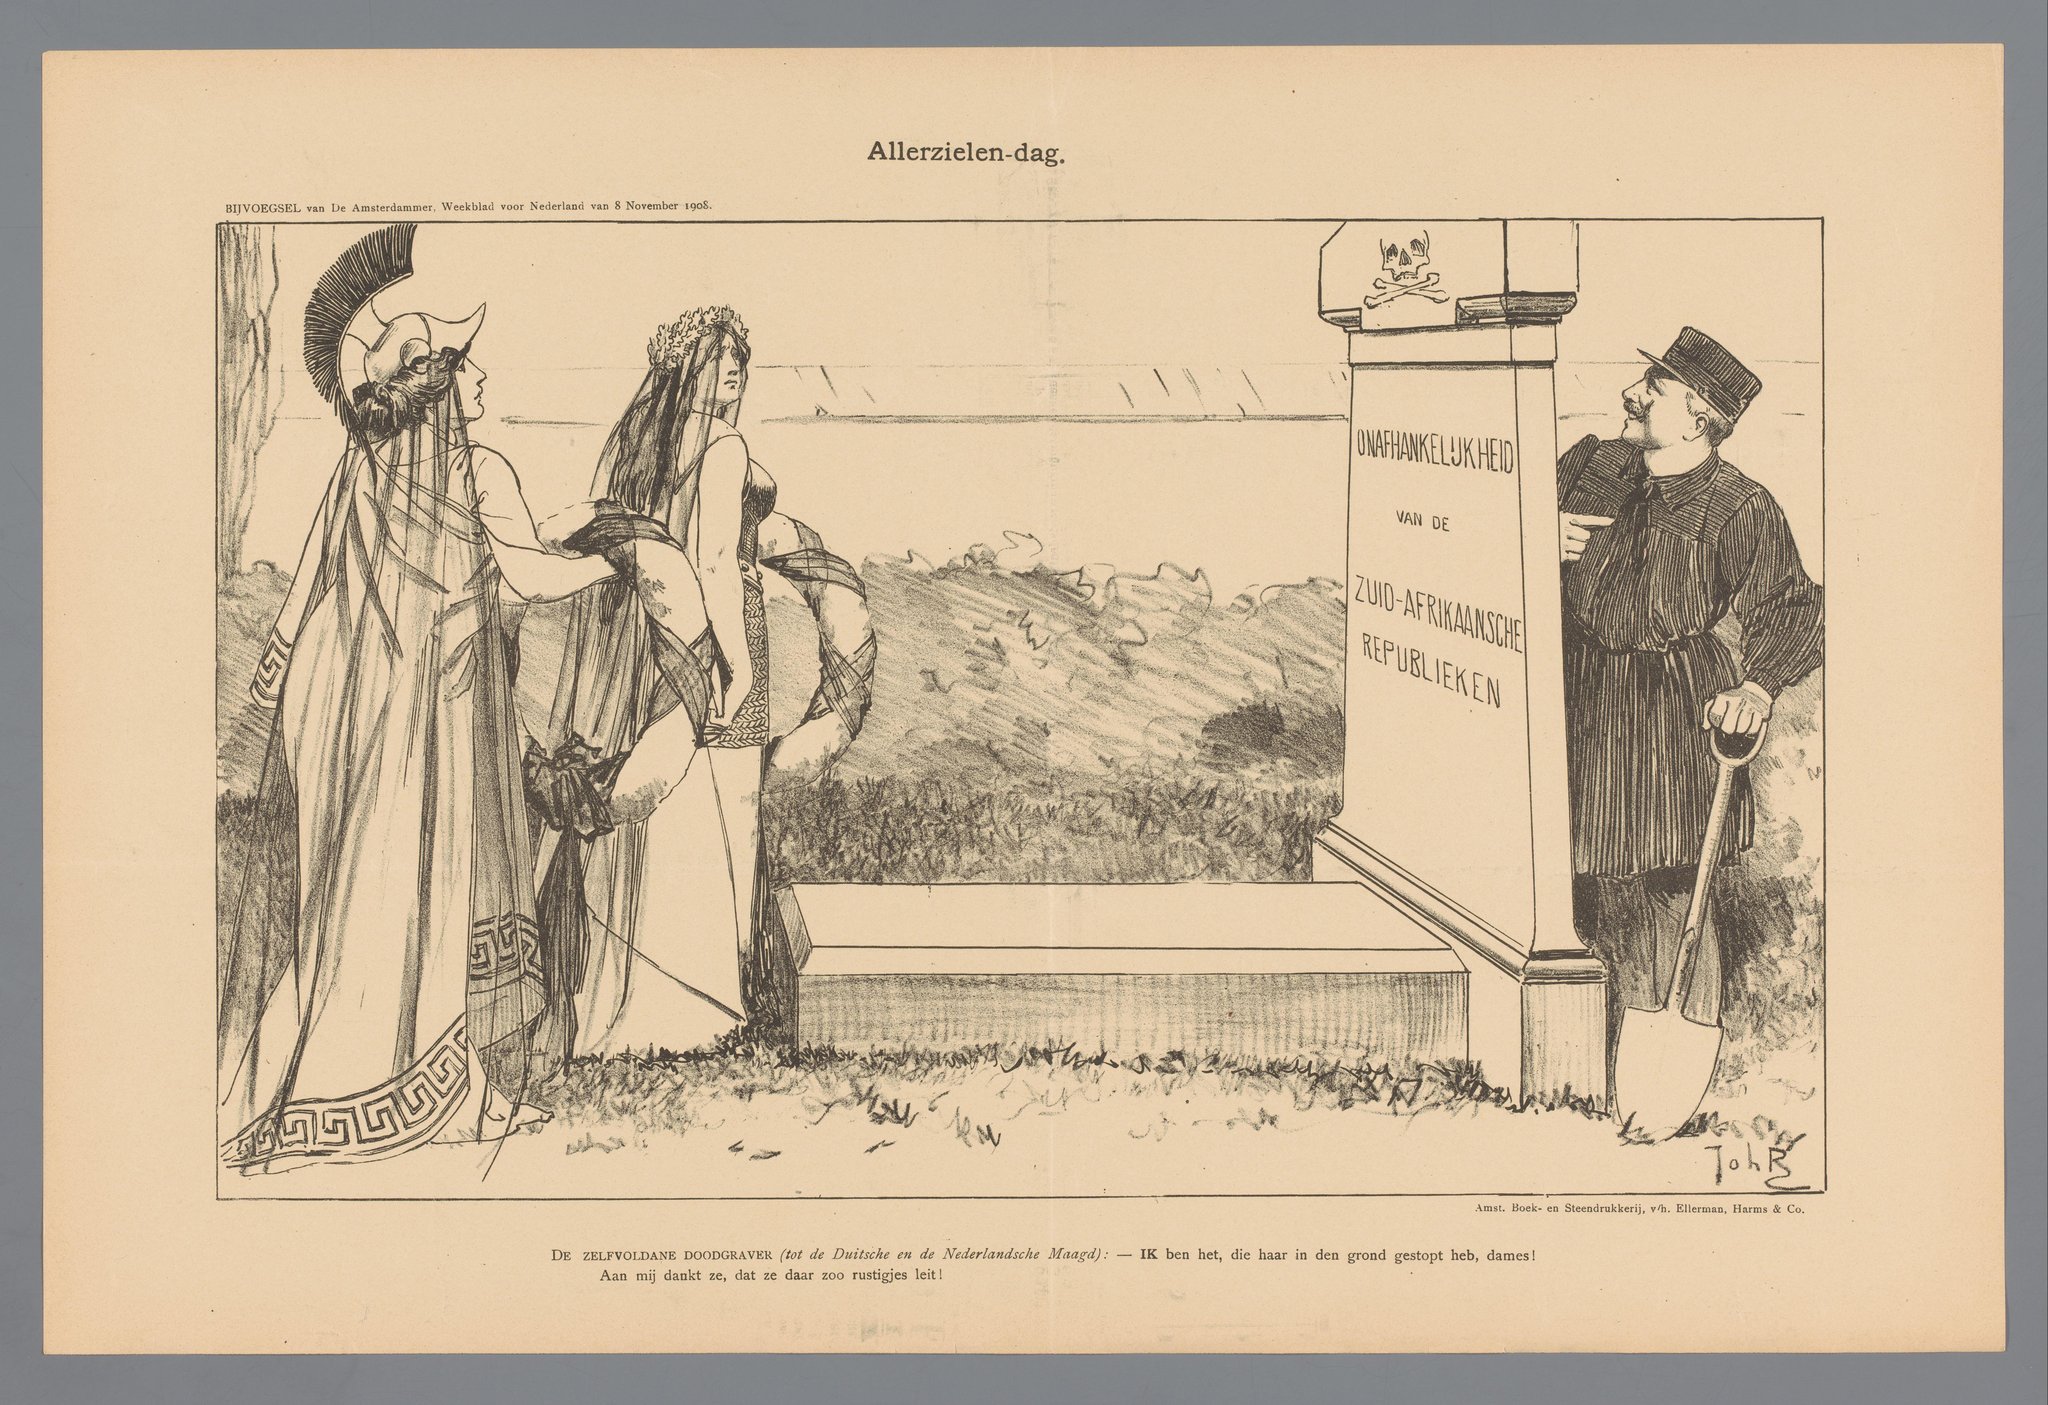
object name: cartoon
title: Allerzielen-dag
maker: johan braakensiek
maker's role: draughtsman, print maker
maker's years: 1858-1940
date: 1908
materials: paper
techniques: lithograph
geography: amsterdam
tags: wilhelm ii (keizer van duitsland), personifications of countries, nations, states, districts, etc. (+ nation; national), grave digger, political caricatures and satires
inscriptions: date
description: Prent uit het bijvoegsel van: De Amsterdammer. Weekblad voor Nederland, 8 november 1908.